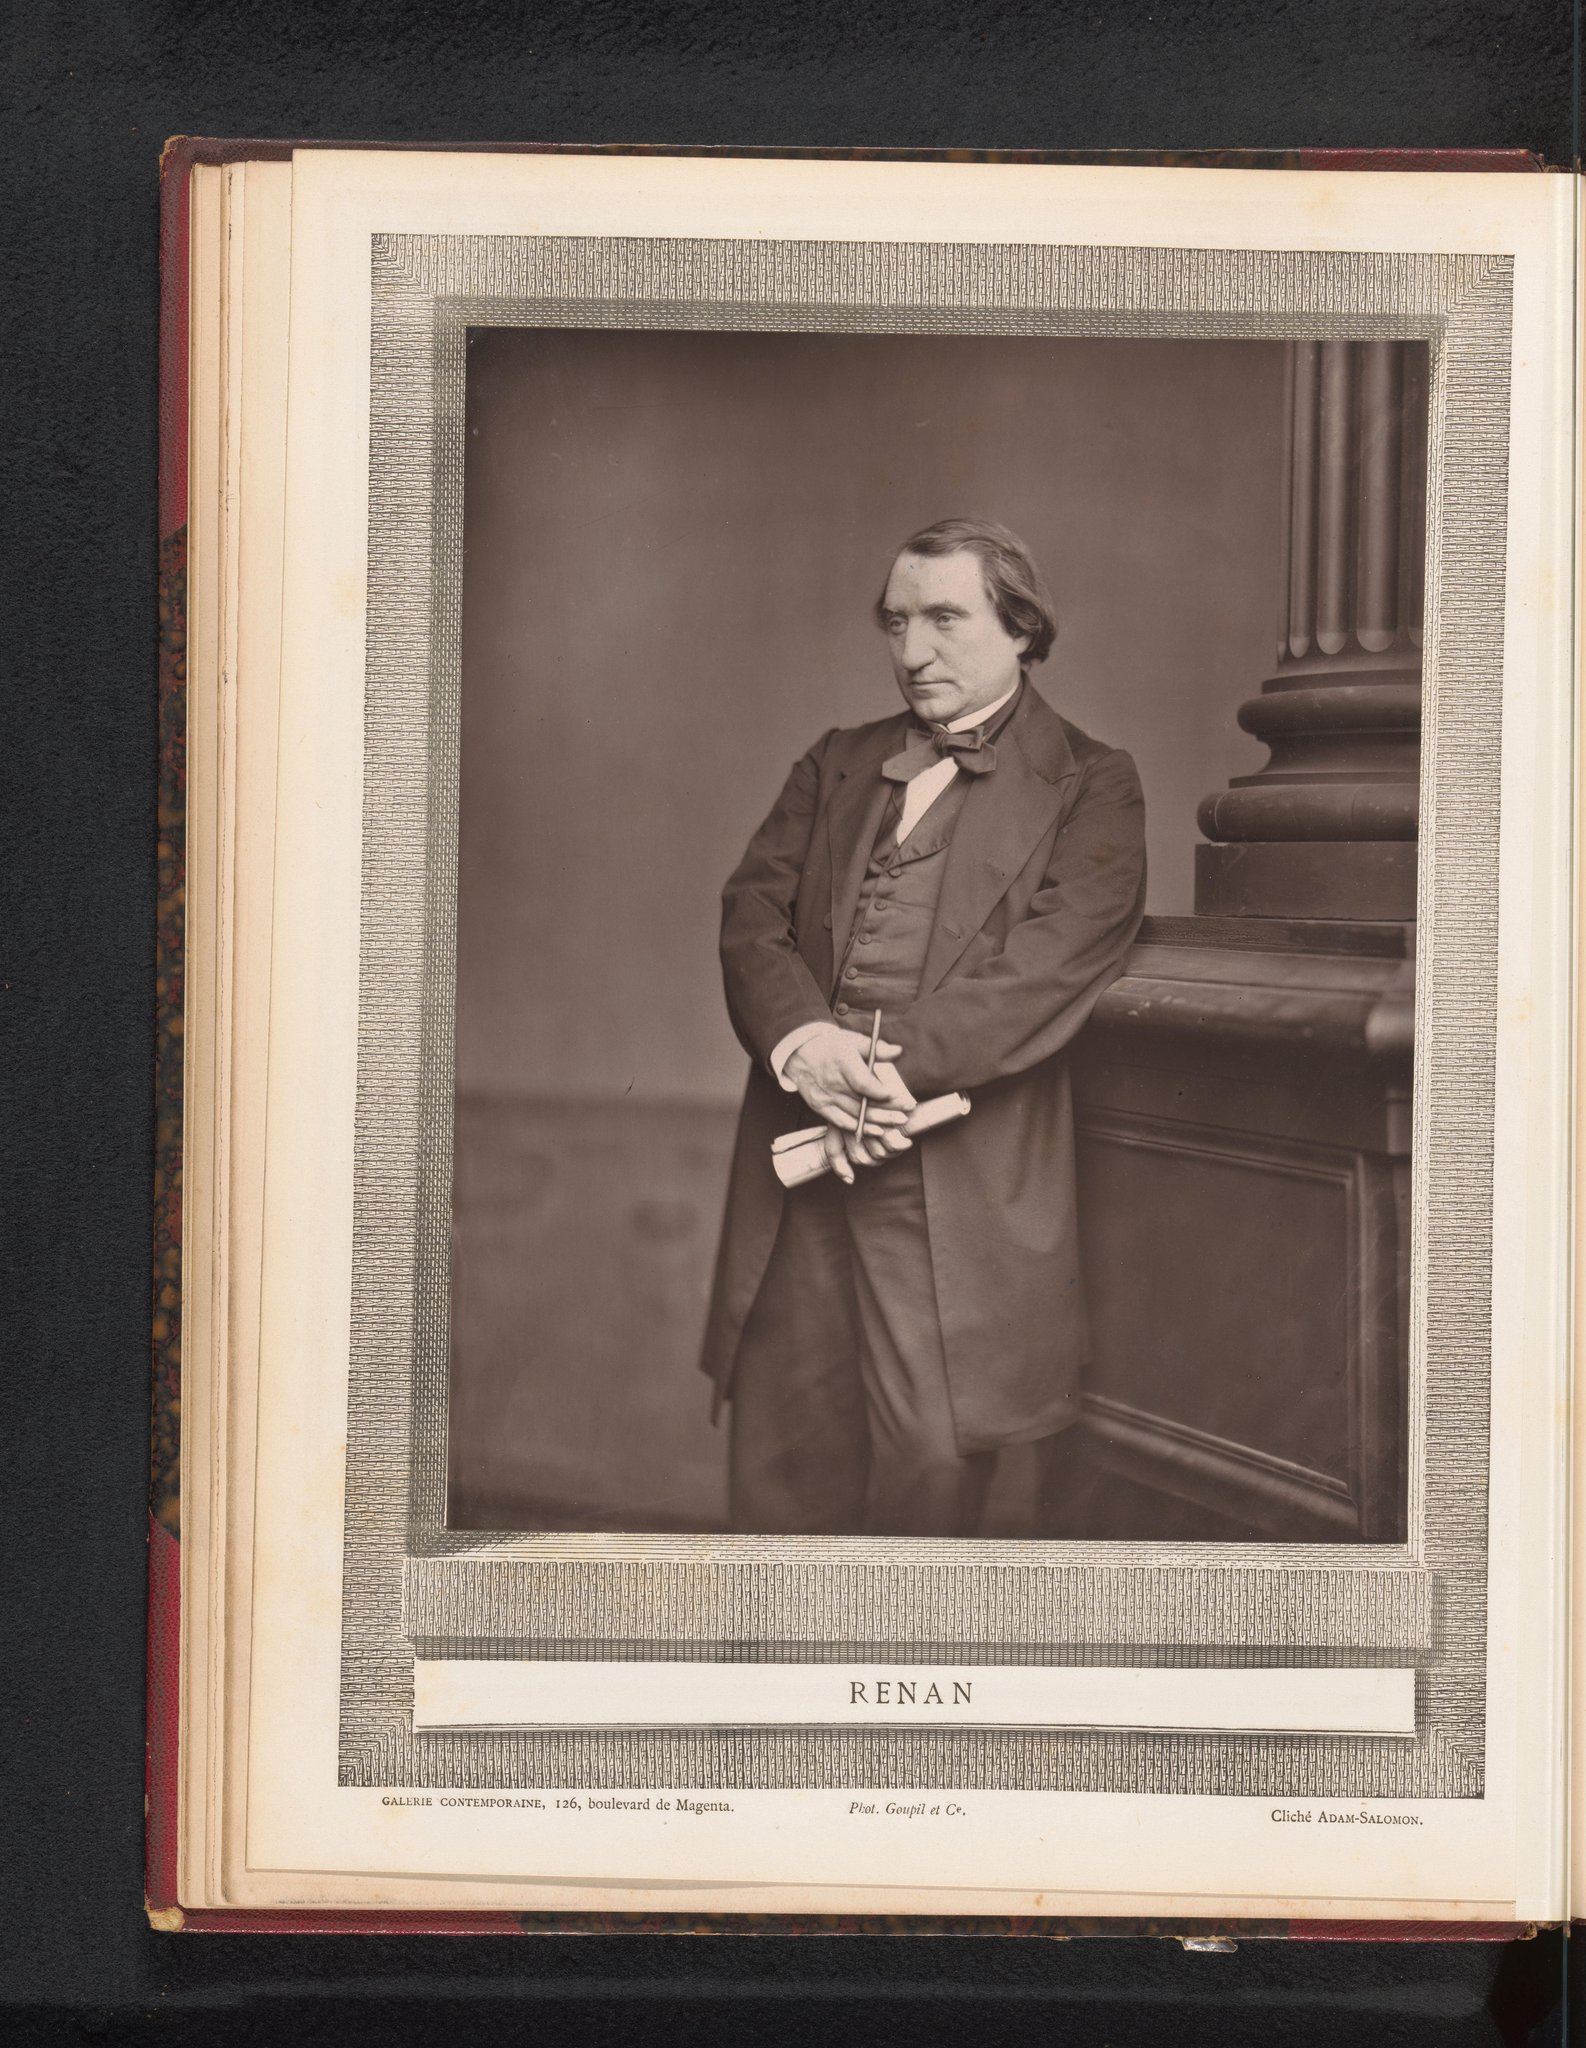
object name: photomechanical print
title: Ranan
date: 1871-1876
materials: paper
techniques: woodburytype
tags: adult man, historical persons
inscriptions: inscription: ‘Galerie Contemporaine, 126, boulevard de Magenta.’